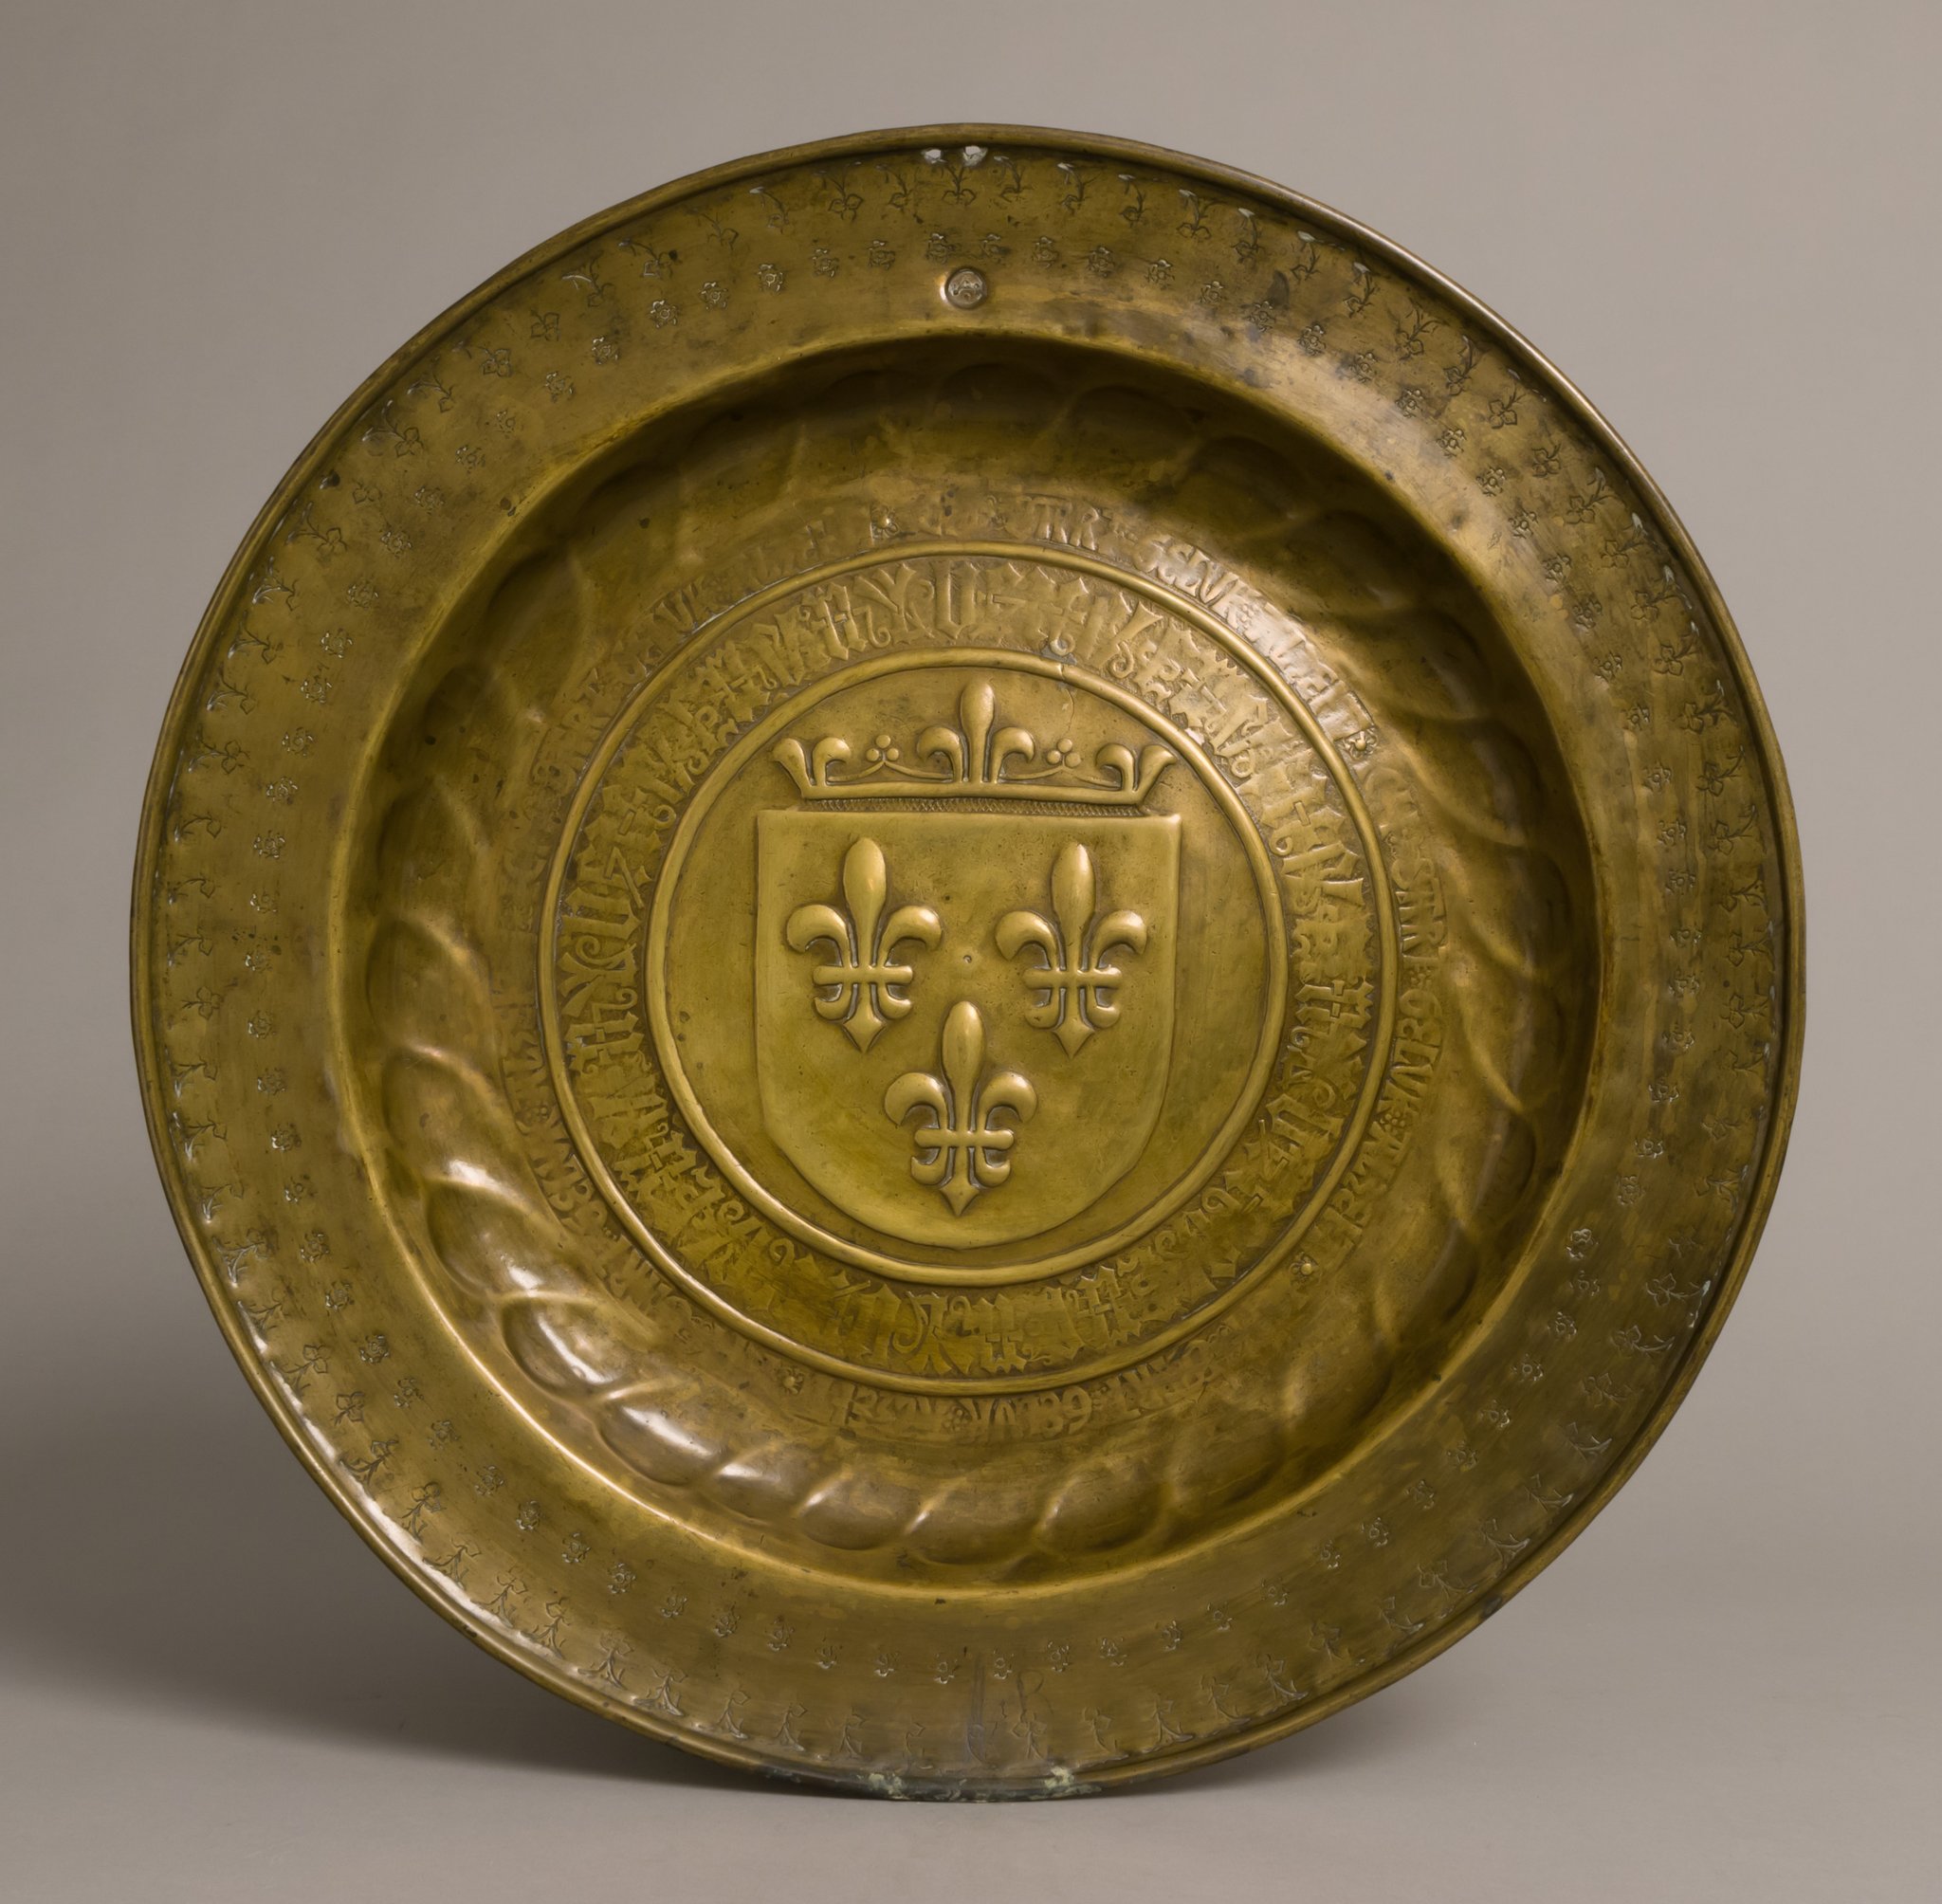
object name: plate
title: Plate, Royal Arms of France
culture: south netherlandish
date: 1467-1500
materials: brass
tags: coat of arms